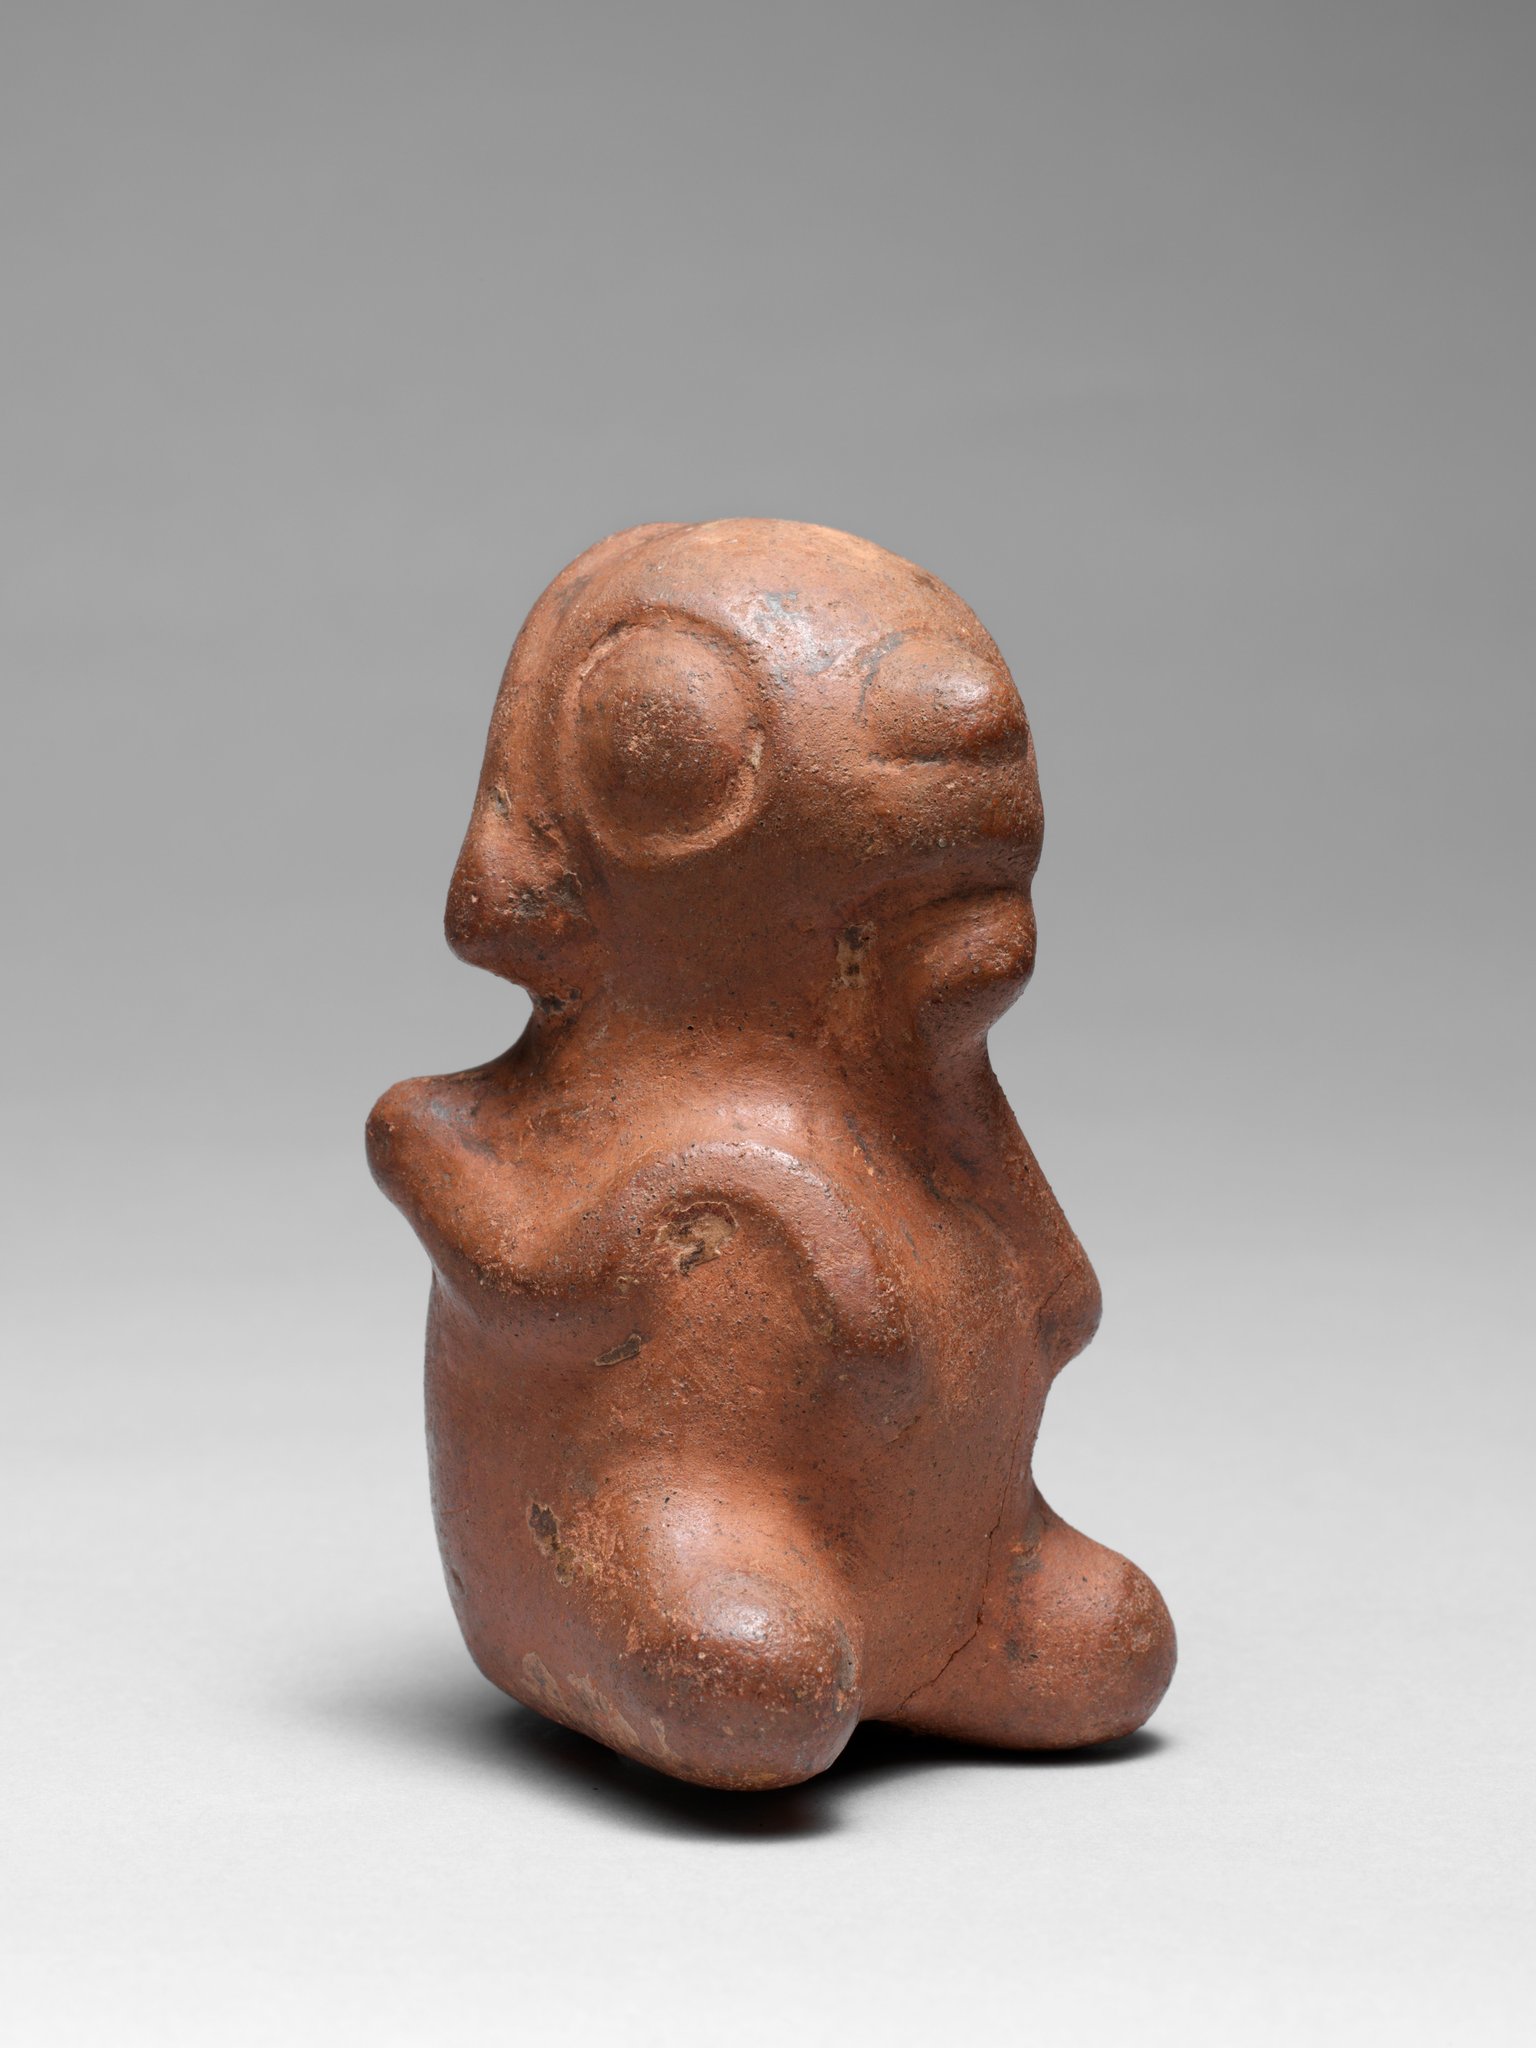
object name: pottery whistle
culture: costa rican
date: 800-1100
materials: clay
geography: costa rica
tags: animals